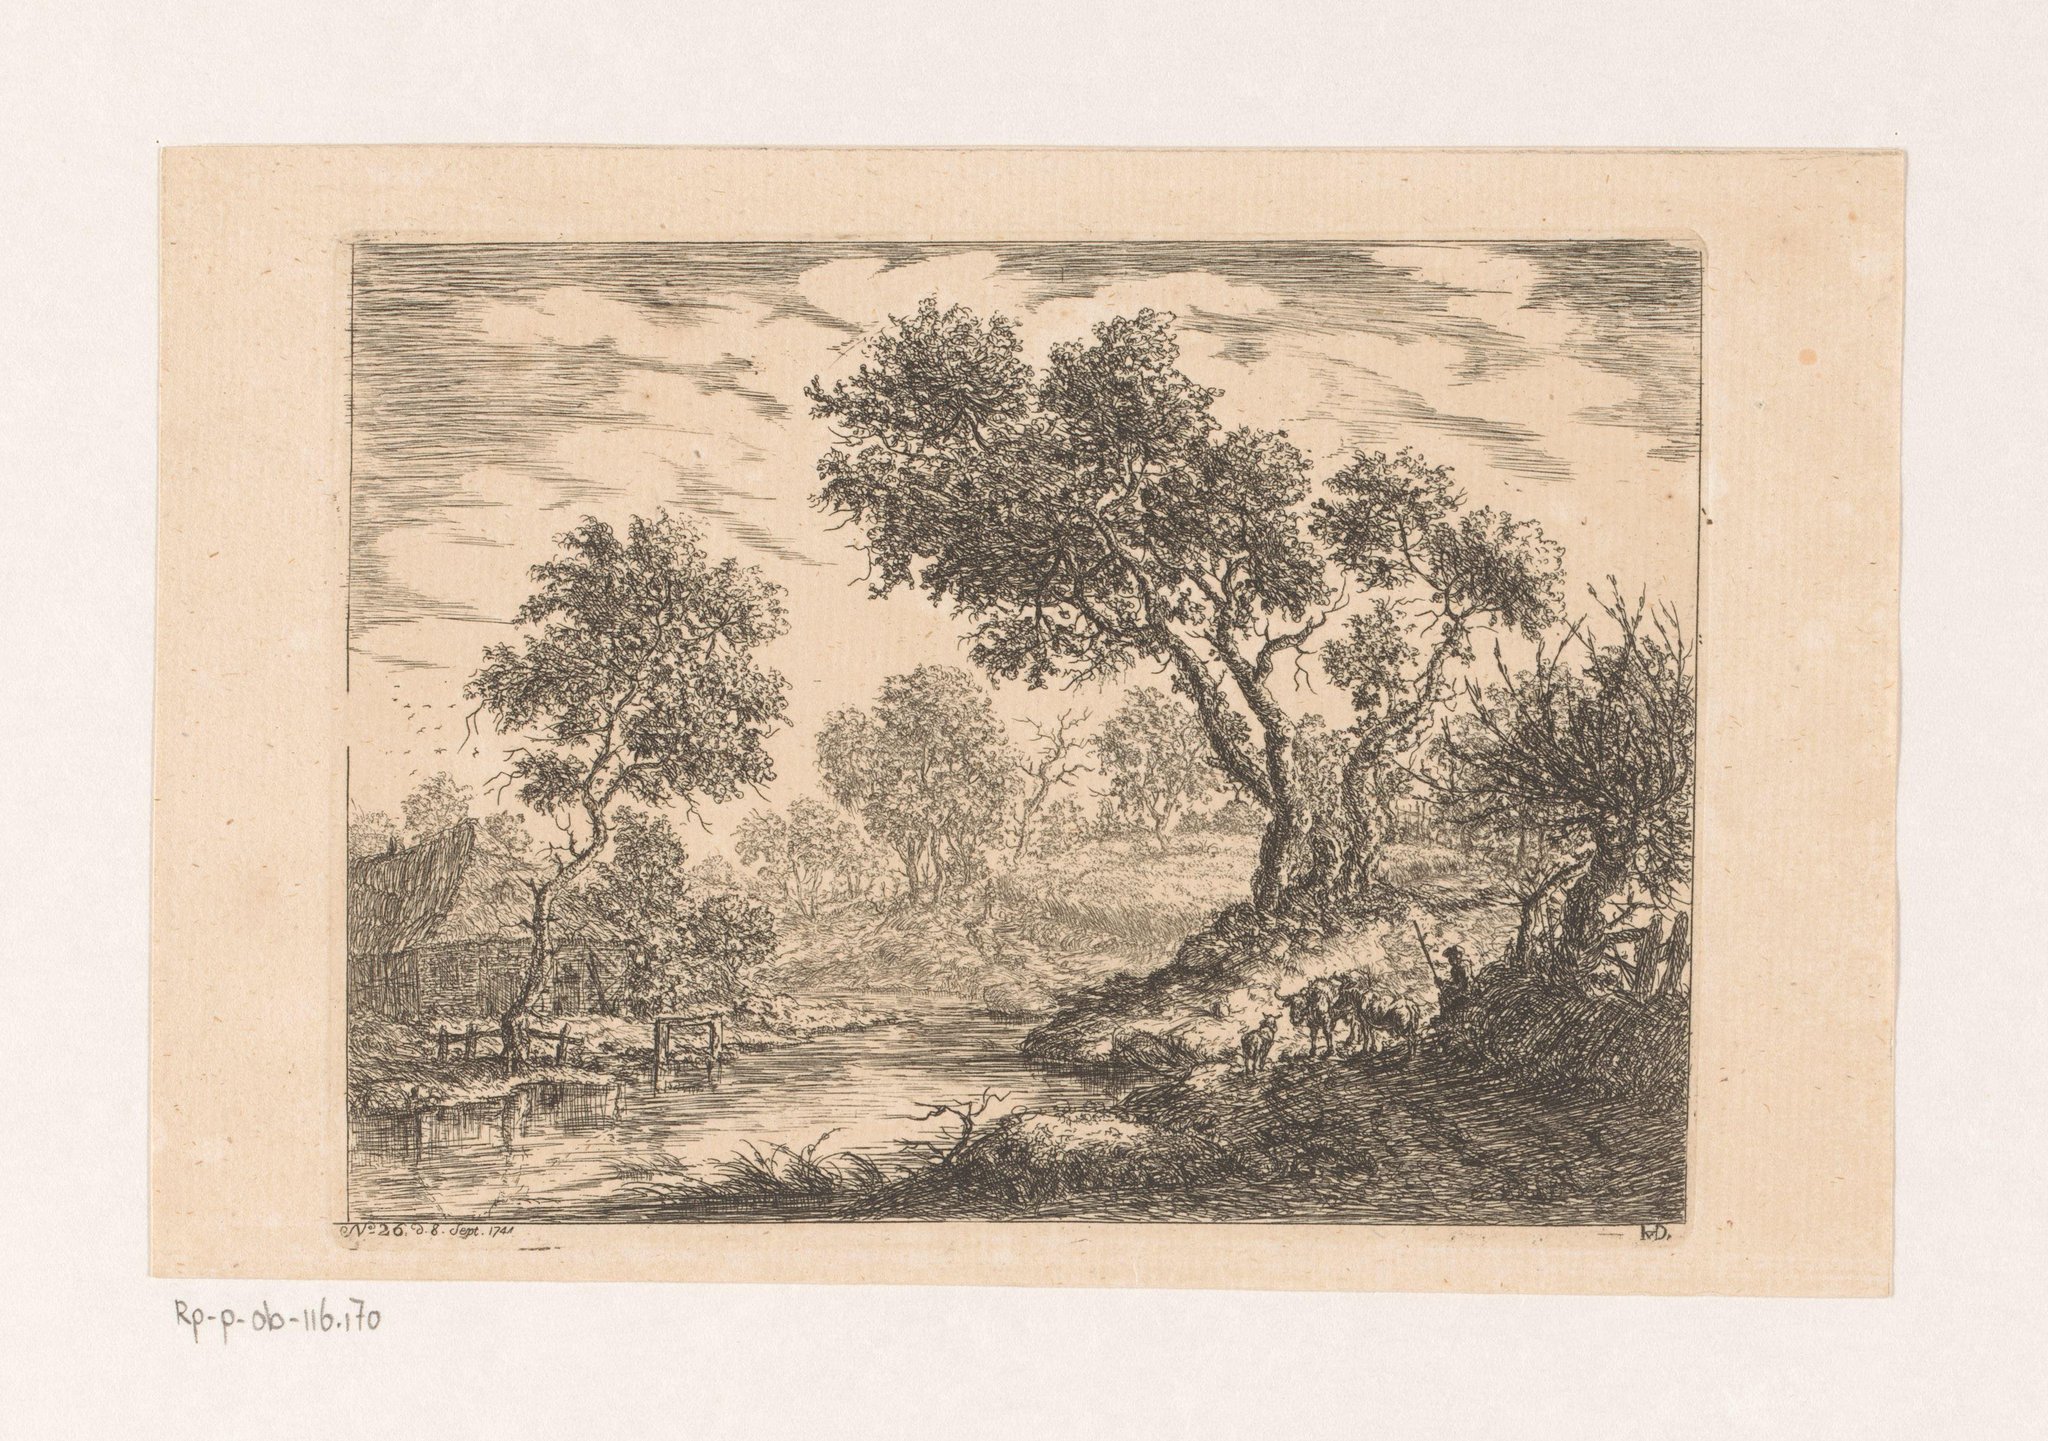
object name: print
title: Landschap met boerderij aan het water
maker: christian ludwig von hagedorn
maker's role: painter, print maker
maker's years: 1712-1780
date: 1744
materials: paper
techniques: etching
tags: herding, herdsman, herdswoman, shepherd, shepherdess, cowherd, etc., farm or solitary house in landscape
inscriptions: collector's mark: Lugt 240